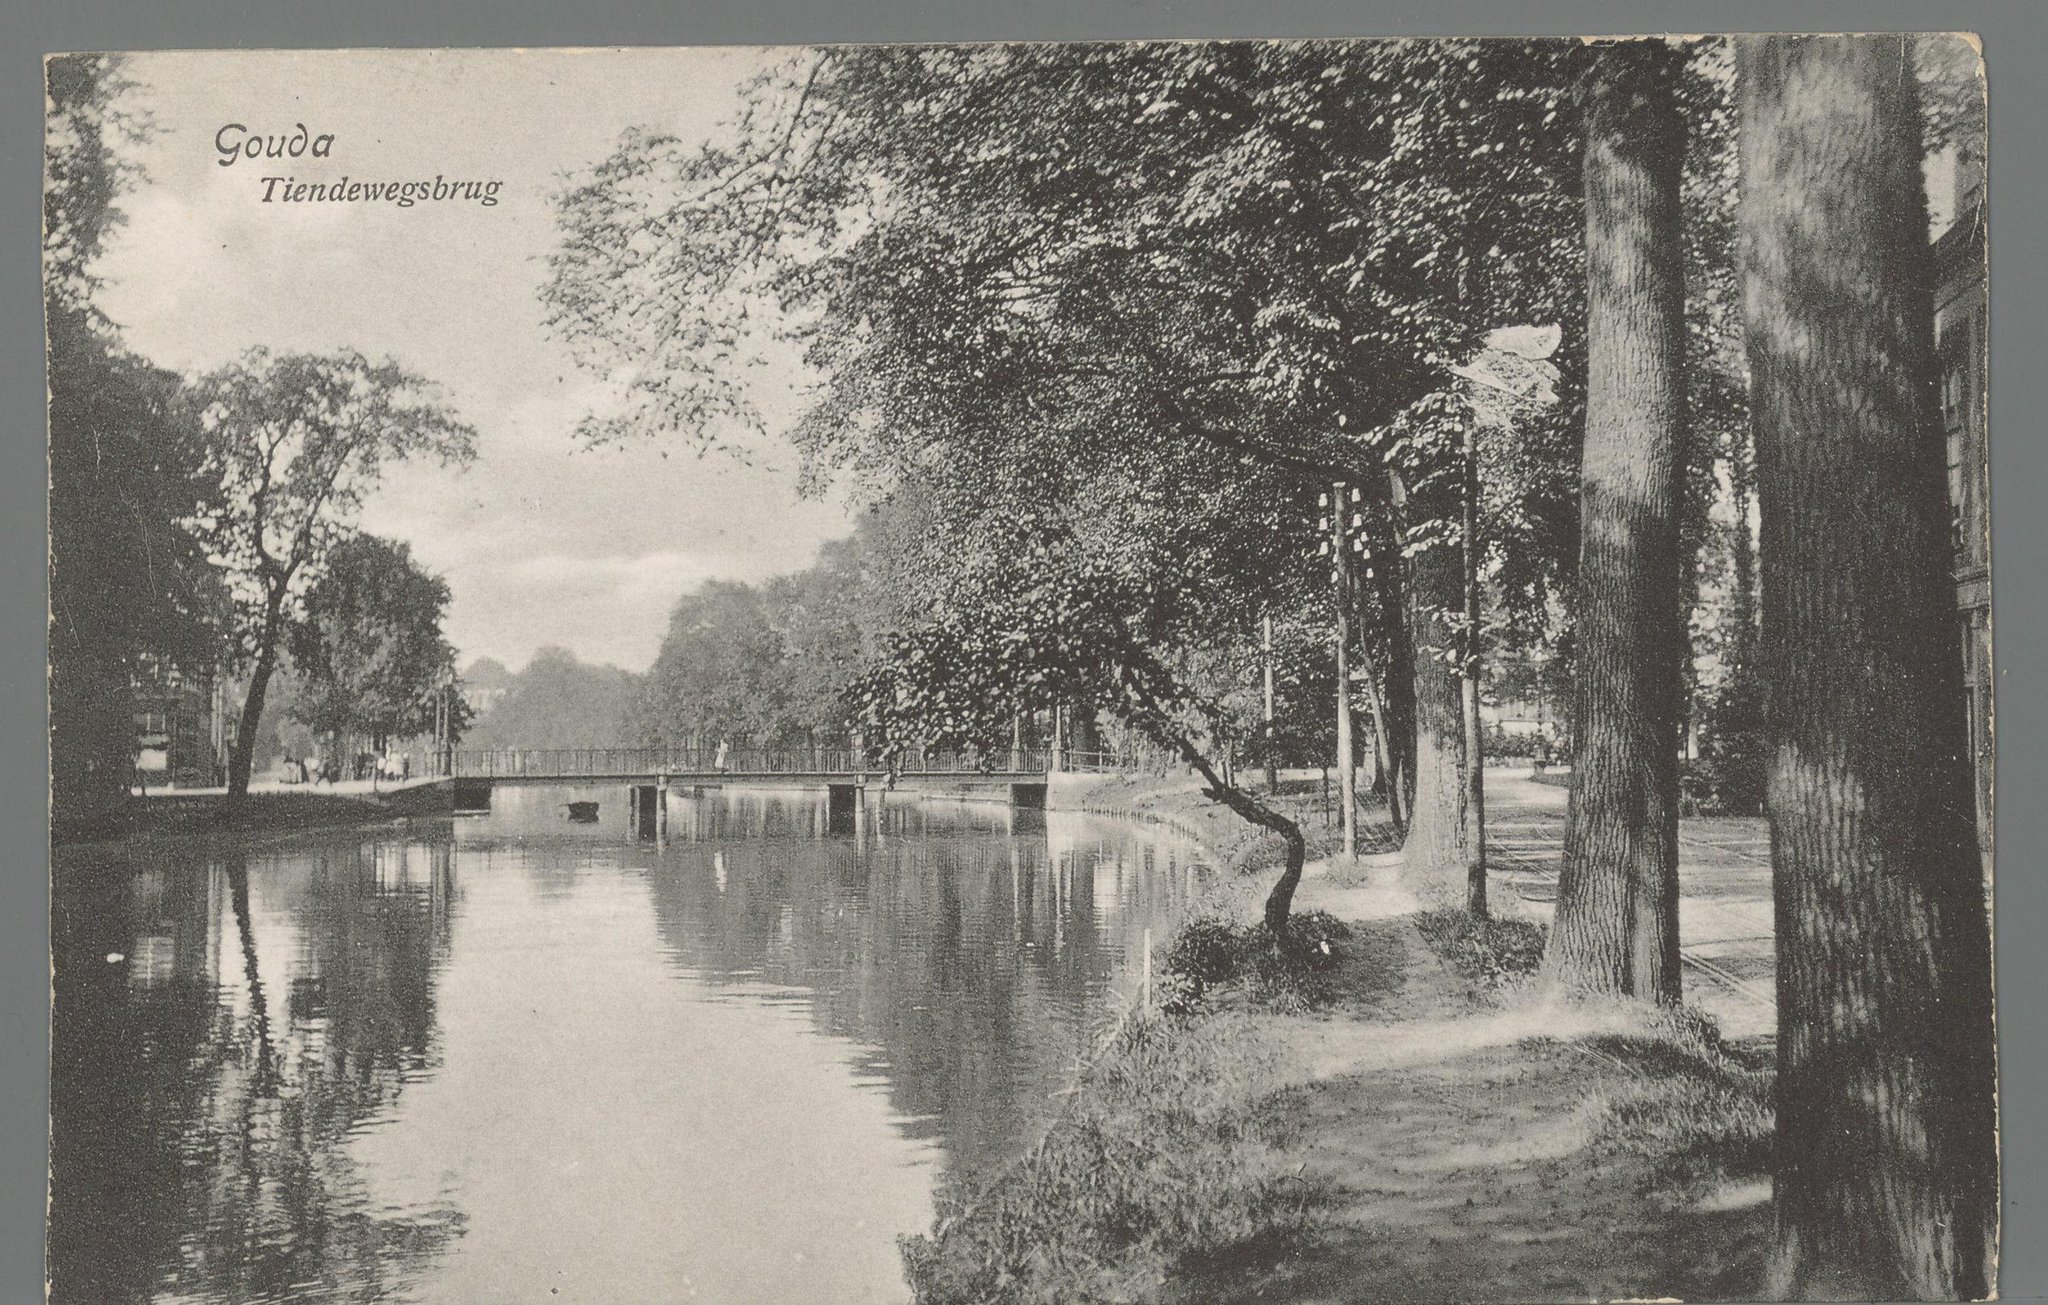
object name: ansichtkaart, prentbriefkaart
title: Gouda. Tiendewegsbrug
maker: Anonymous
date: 1908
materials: cardboard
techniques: photograph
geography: gouda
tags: canals, waters (in village), bridge in village across river, canal, etc., gouda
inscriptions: date